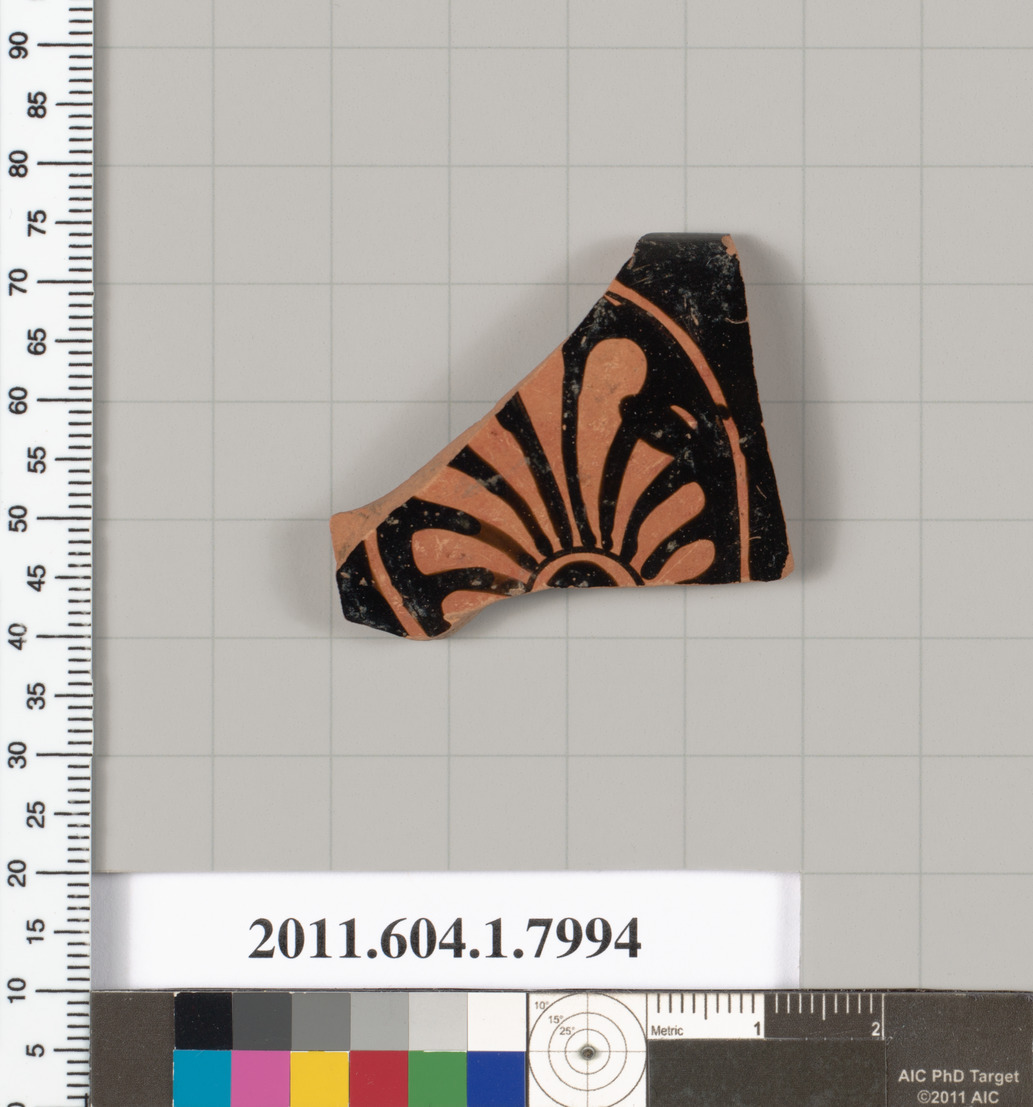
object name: kylix fragment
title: Terracotta rim fragment of a kylix (drinking cup)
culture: greek, attic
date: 460-450 BCE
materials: terracotta